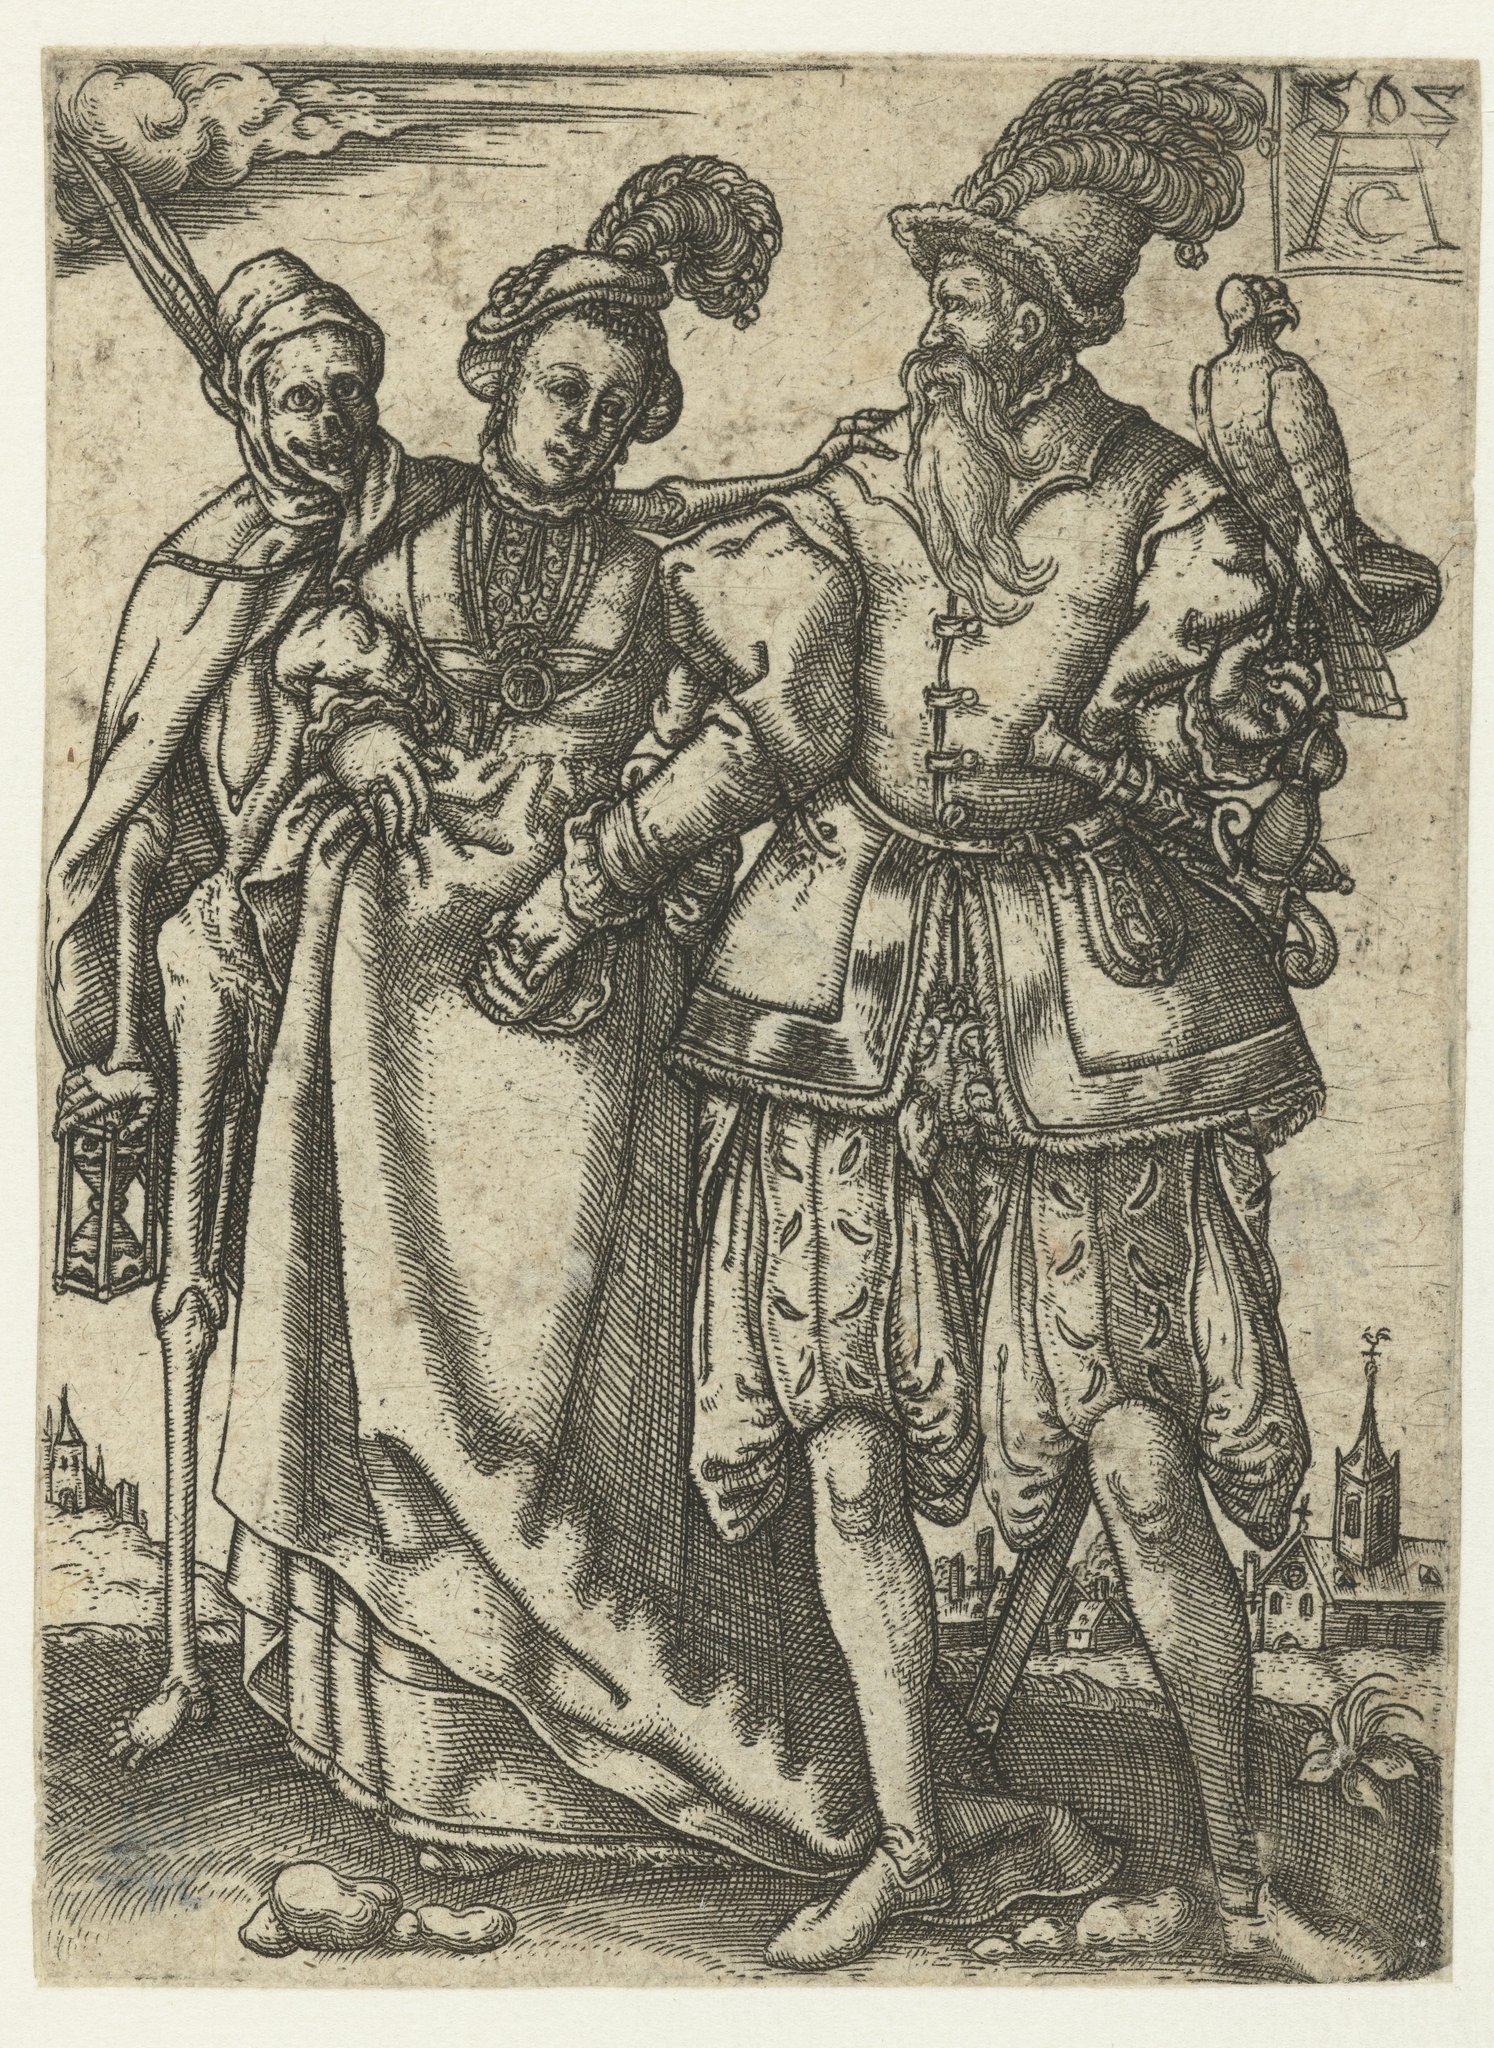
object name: print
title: Echtpaar met de Dood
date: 1562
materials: paper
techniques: engraving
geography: low countries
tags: dance of death; death together with one or more human beings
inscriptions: collector's mark: Lugt 88, collector's mark: Lugt 2773, collector's mark: Lugt 2228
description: Prent uit een serie van zeven. Vrouw en man met valk op arm, worden omarmd door de Dood met zandloper in rechter hand.